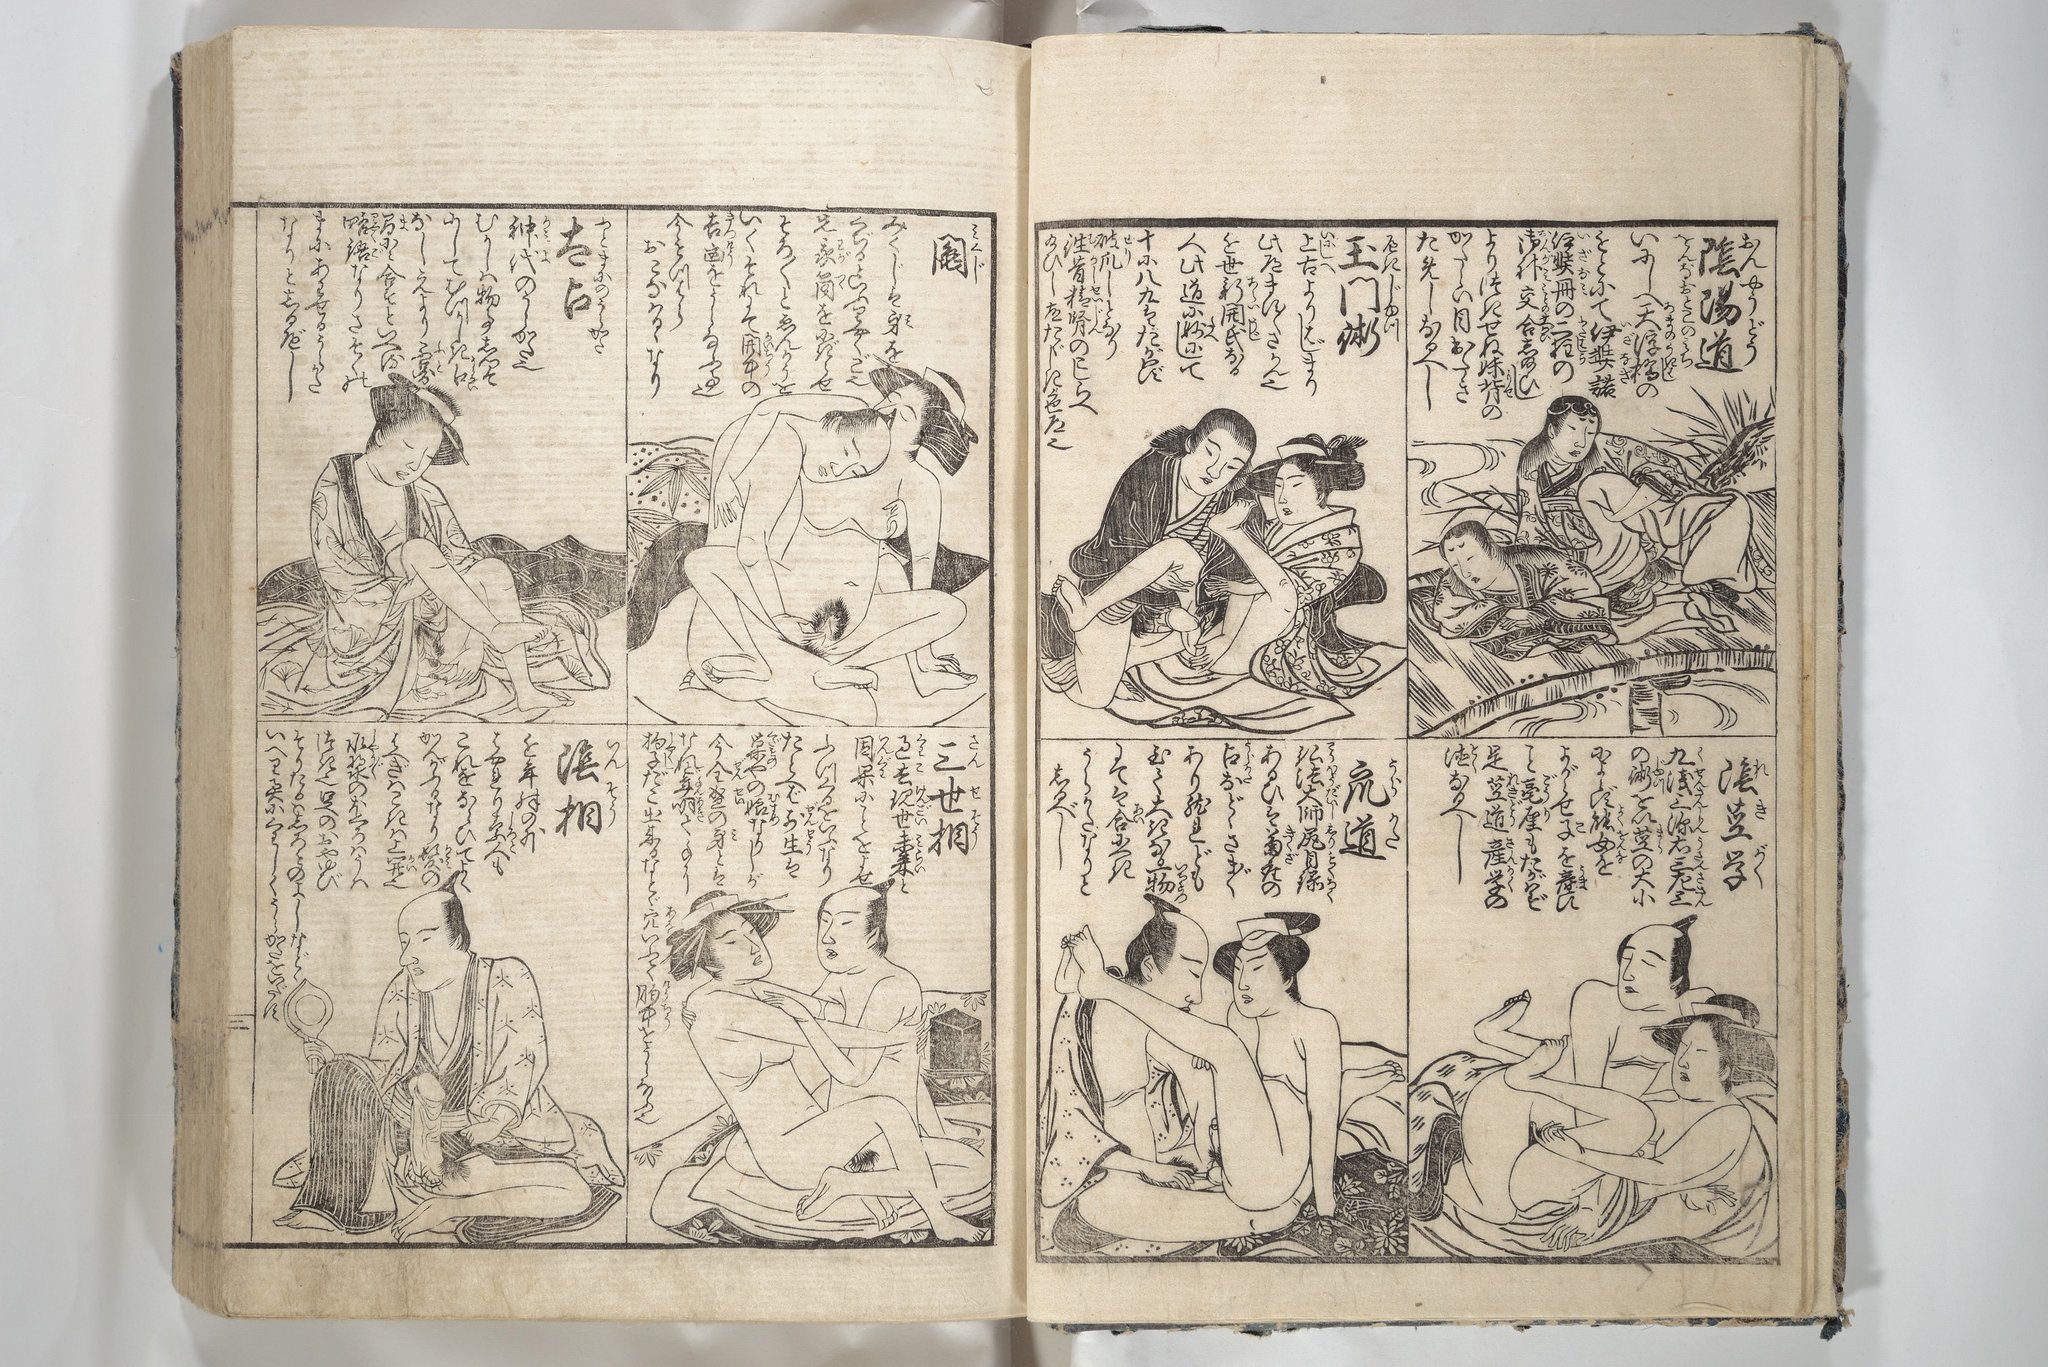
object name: illustrated book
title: Erotica; Compendium Guide to the Brothels of Osaka (Keiryaku ōzassho gyokumon taisei) 閨暦大雑書玉門大成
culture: japanese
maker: kitao shigemasa 北尾重政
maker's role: artist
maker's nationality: japanese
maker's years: 1739-1820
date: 1770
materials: ink, paper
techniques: woodblock print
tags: male nudes,female nudes